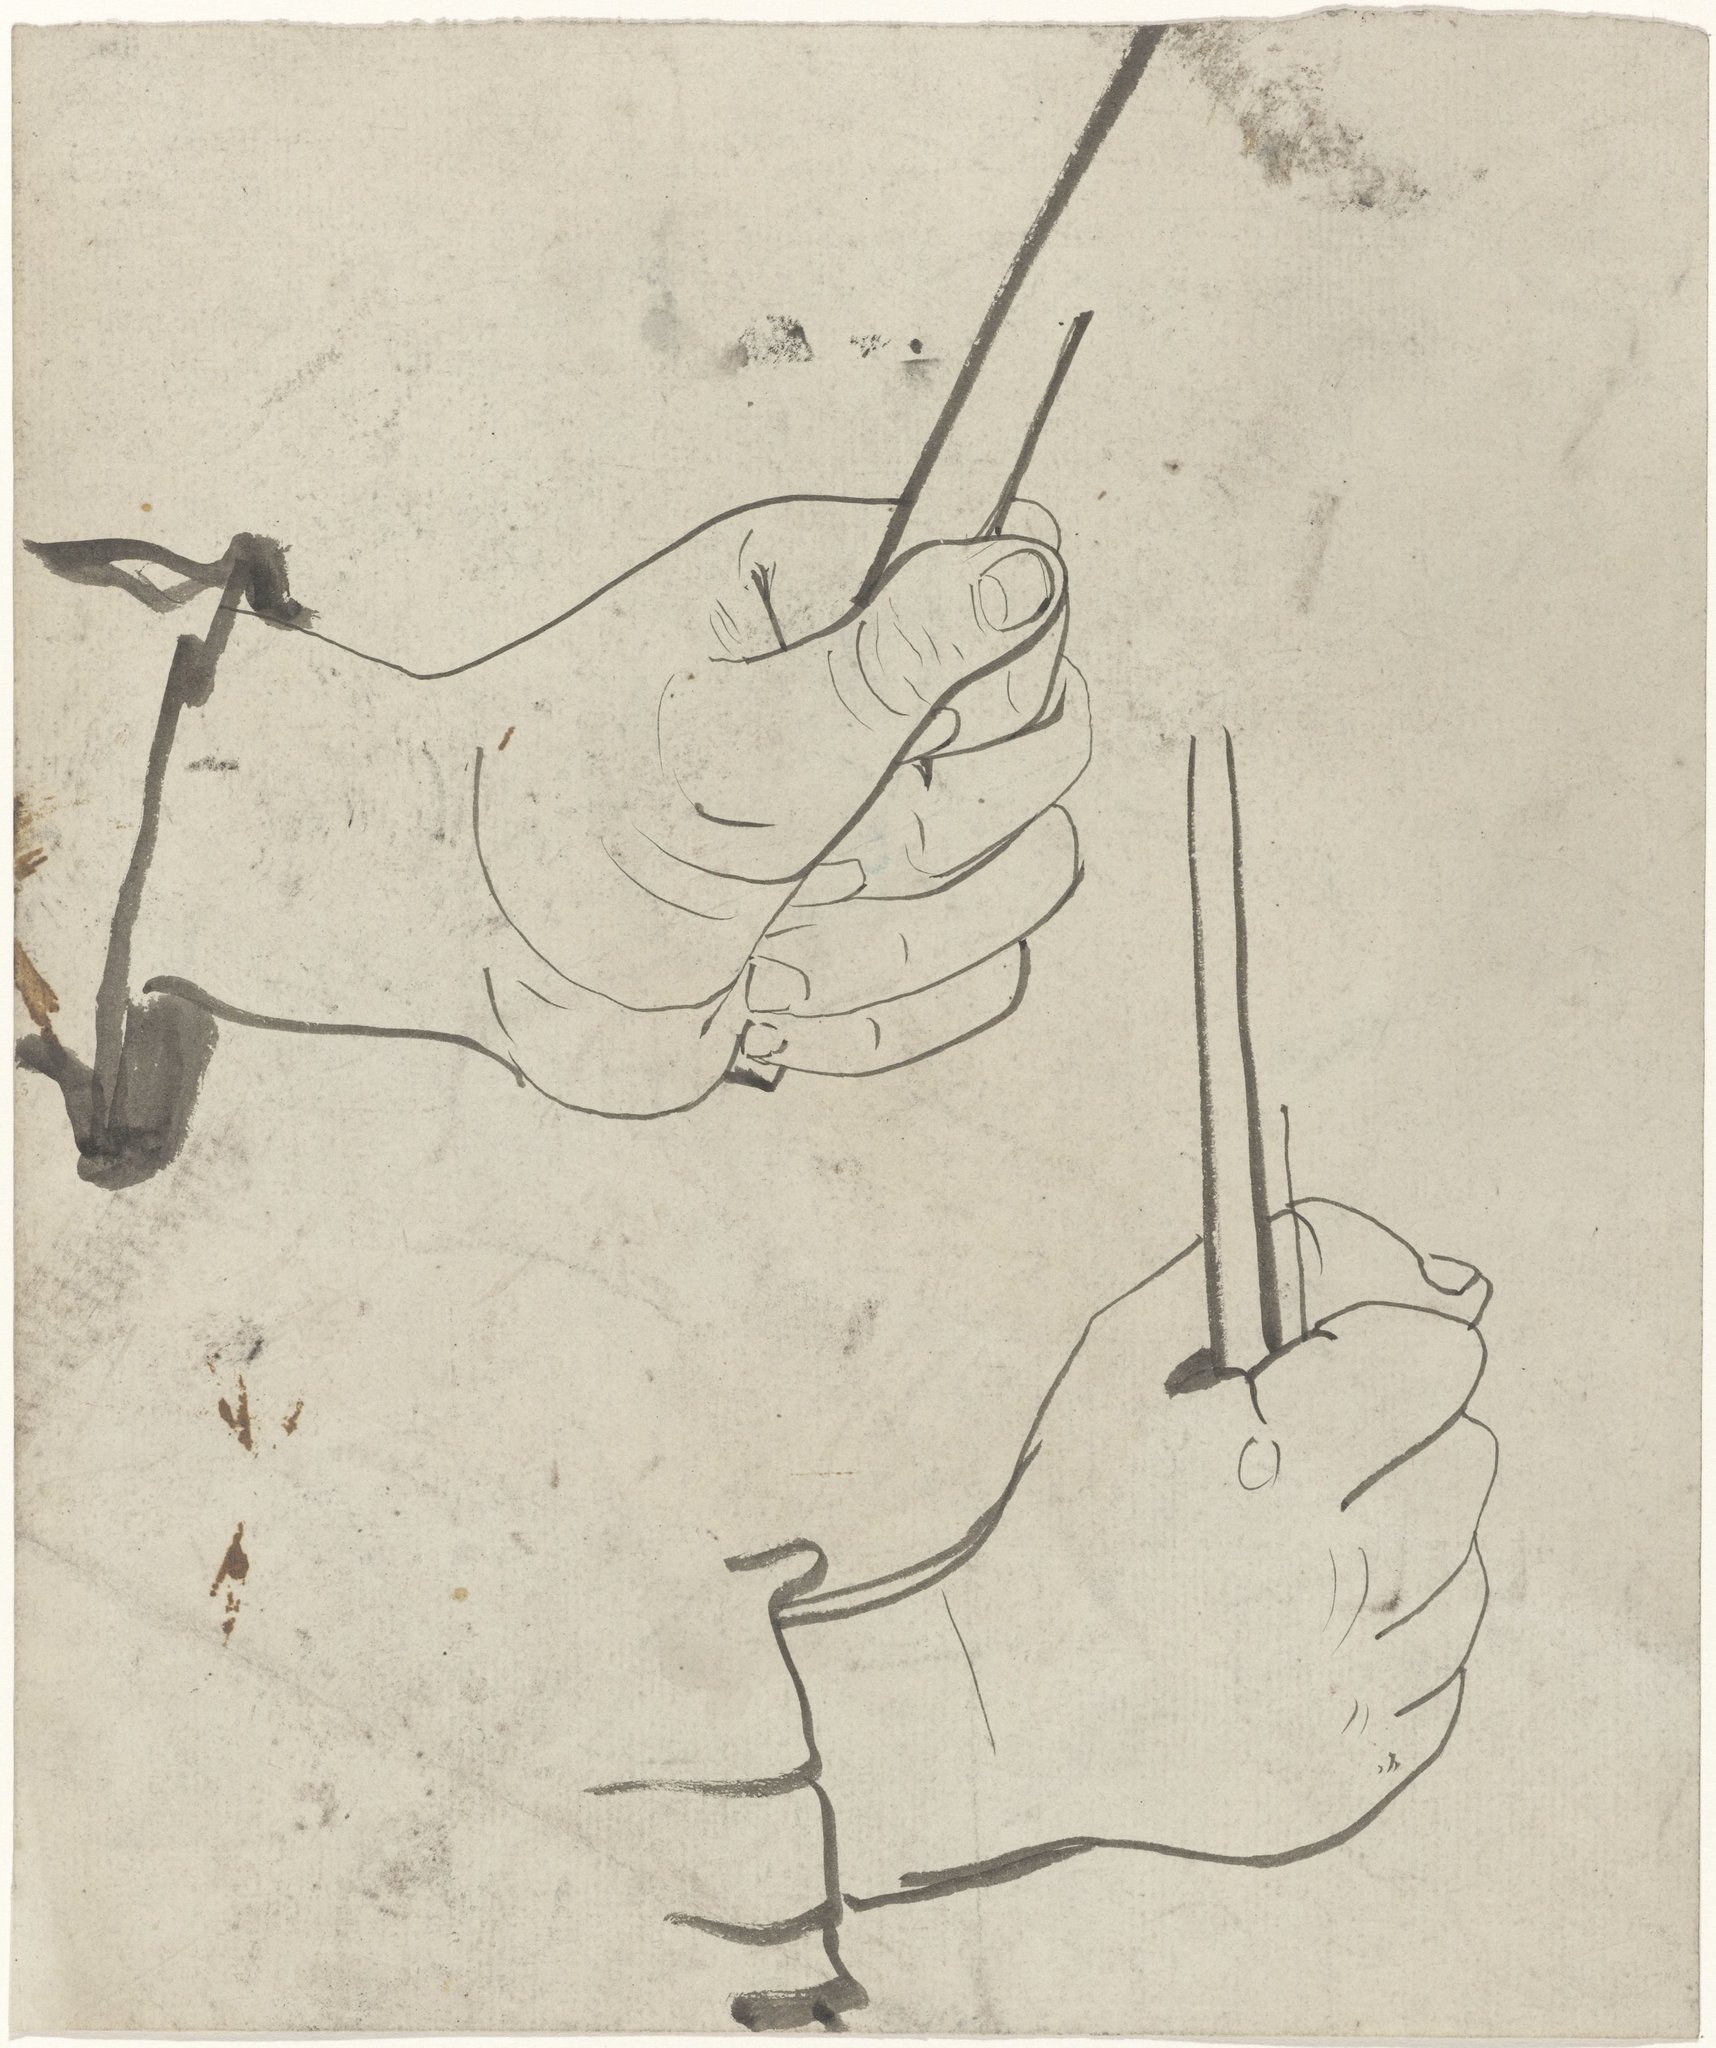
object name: drawing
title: Studie van handen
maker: carel adolph lion cachet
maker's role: draughtsman, print maker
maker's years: 1864-1945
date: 1874-1945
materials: ink, paper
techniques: brush, pen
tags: hand